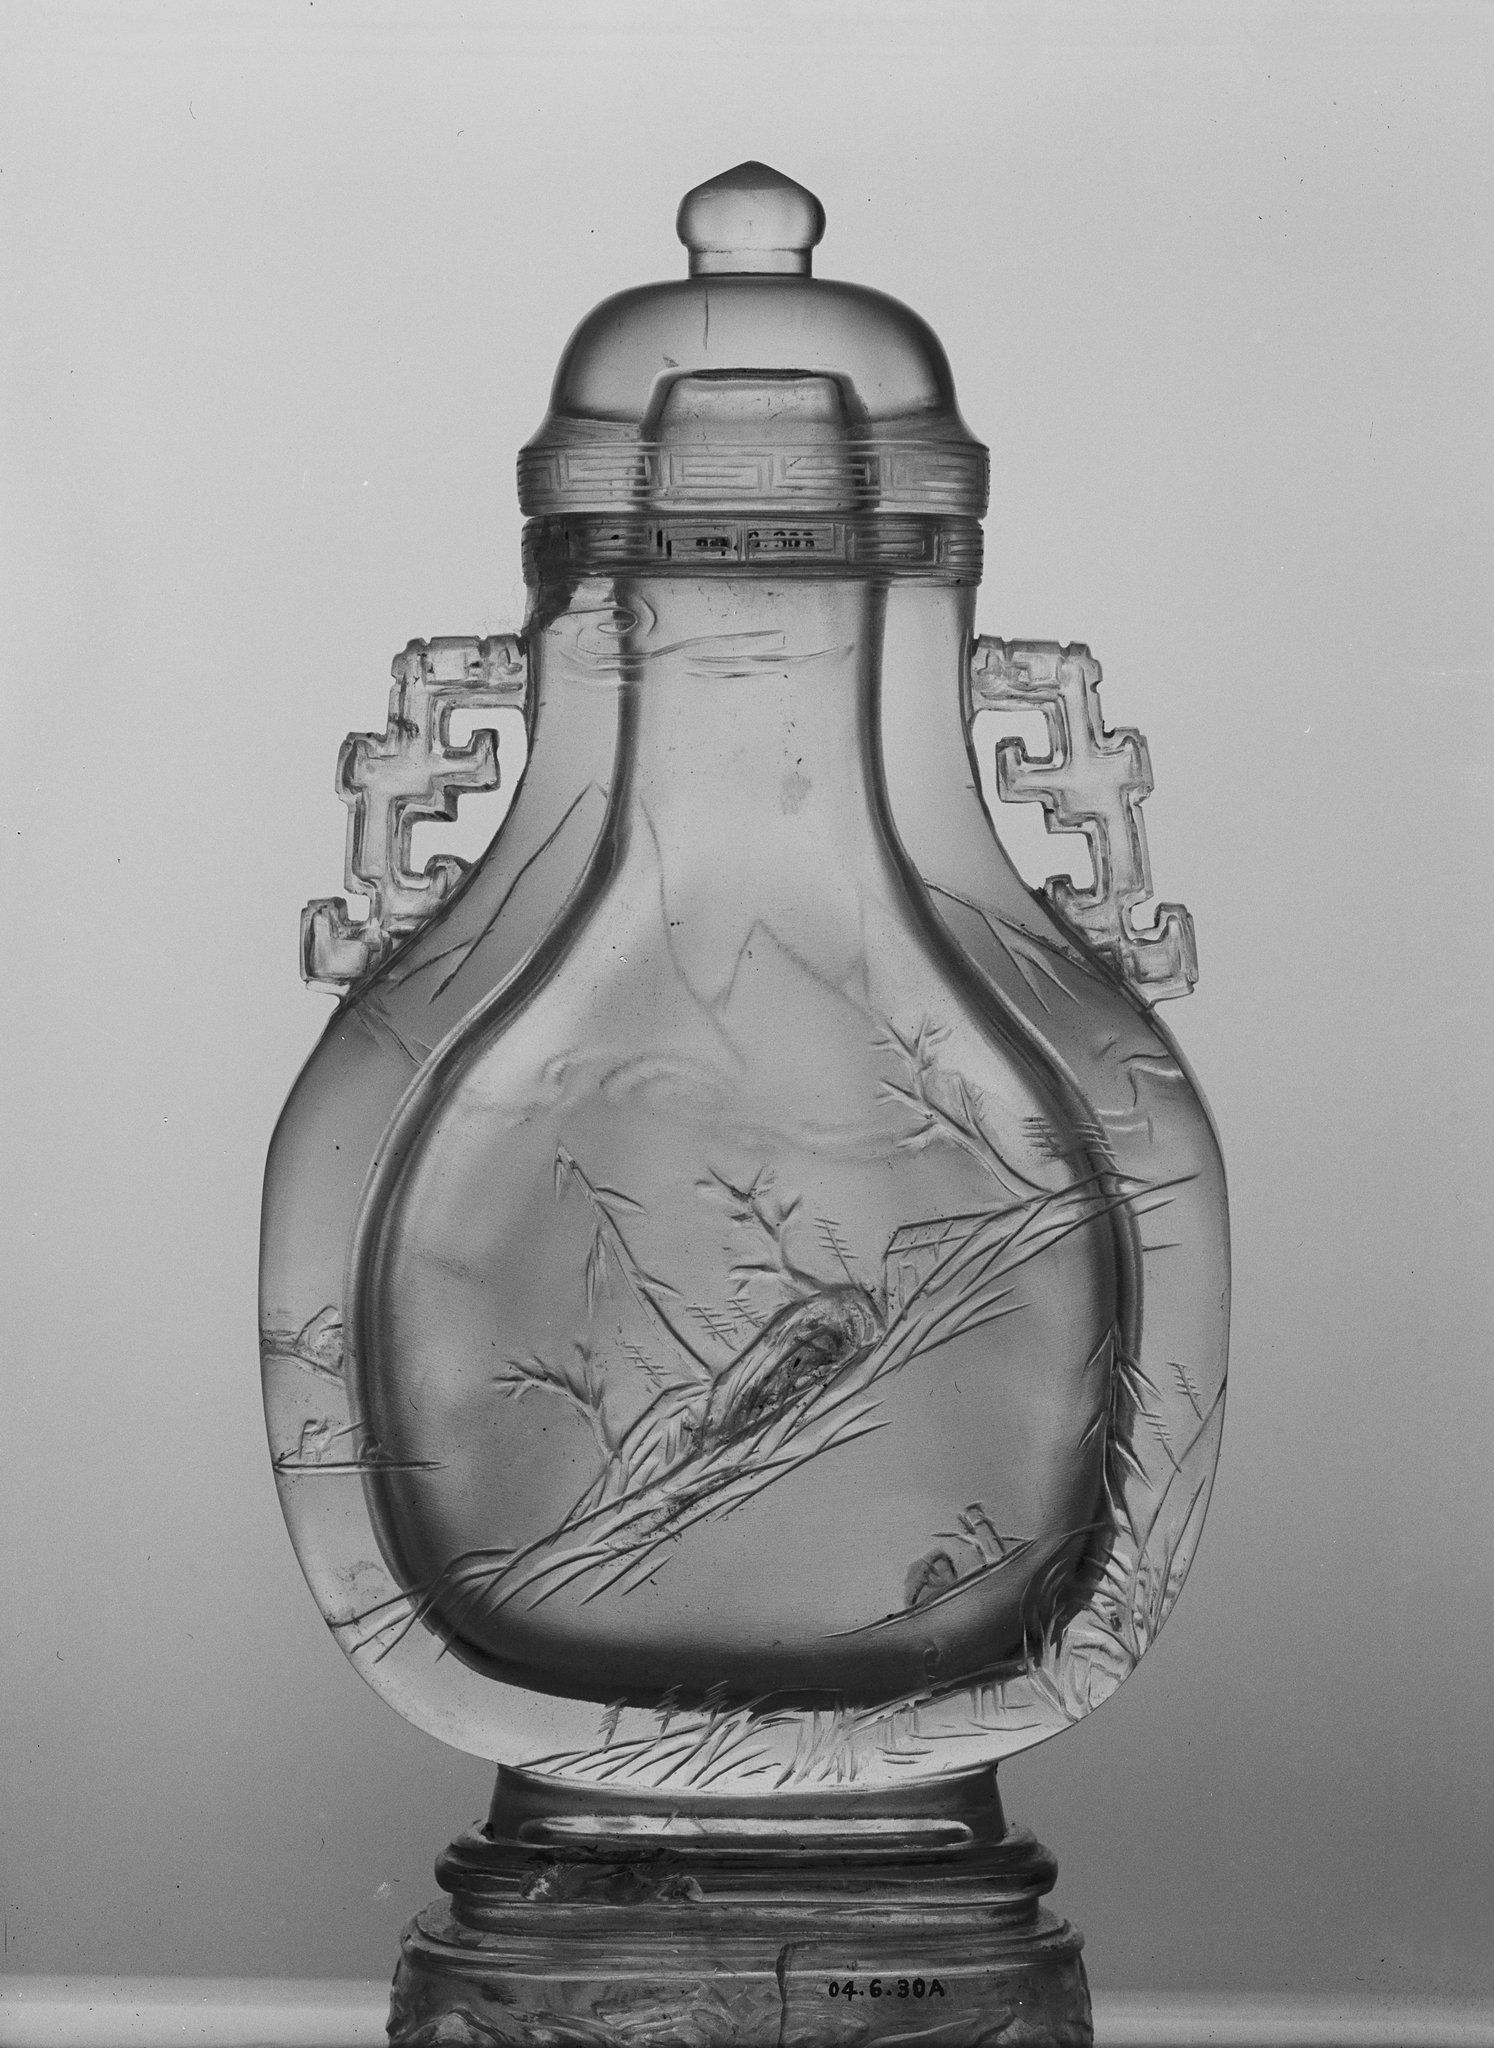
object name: flask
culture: chinese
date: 1801-1900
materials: quartz